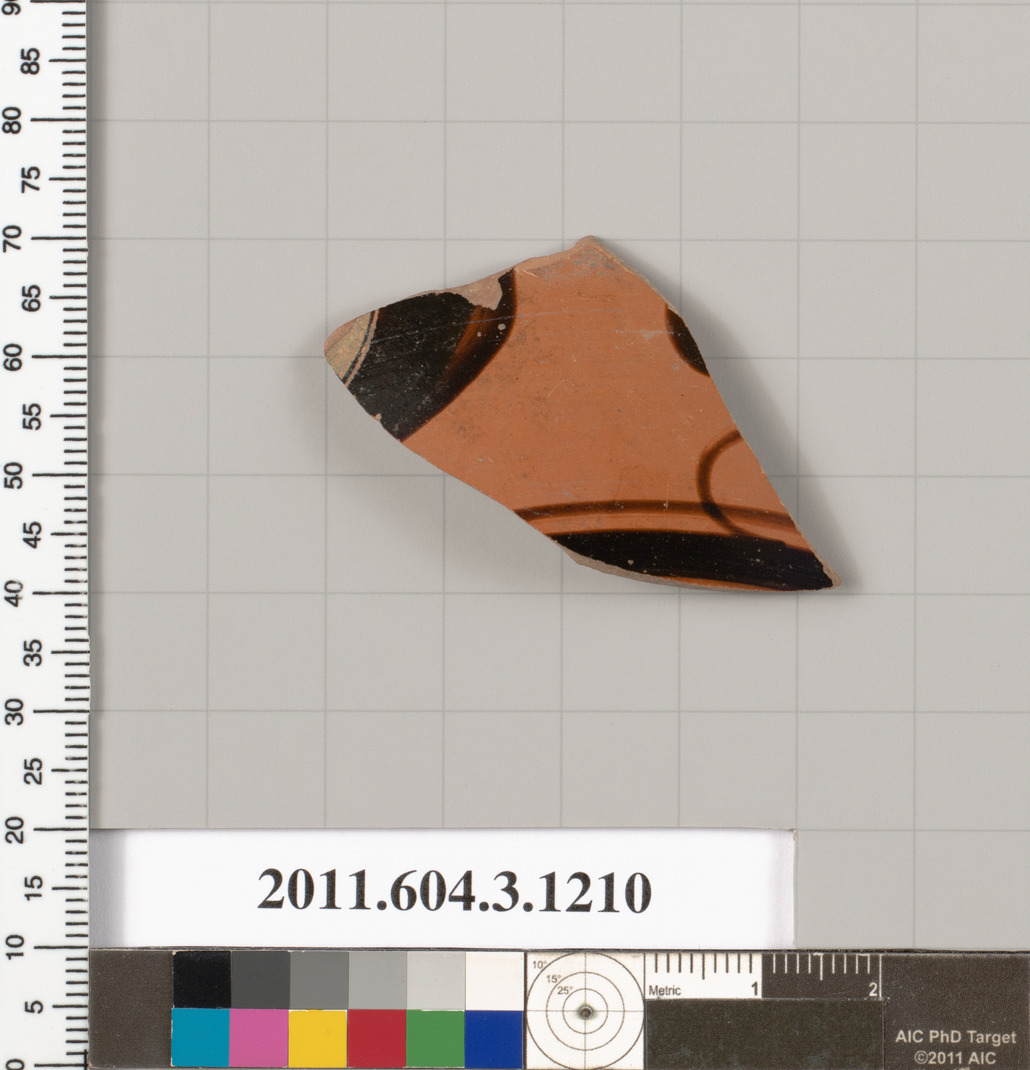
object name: mastoid or kyathos fragment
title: Terracotta fragment of a mastoid (drinking cup with narrow base) or a kyathos (cup-shaped ladle)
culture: greek, attic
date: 534-468 BCE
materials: terracotta